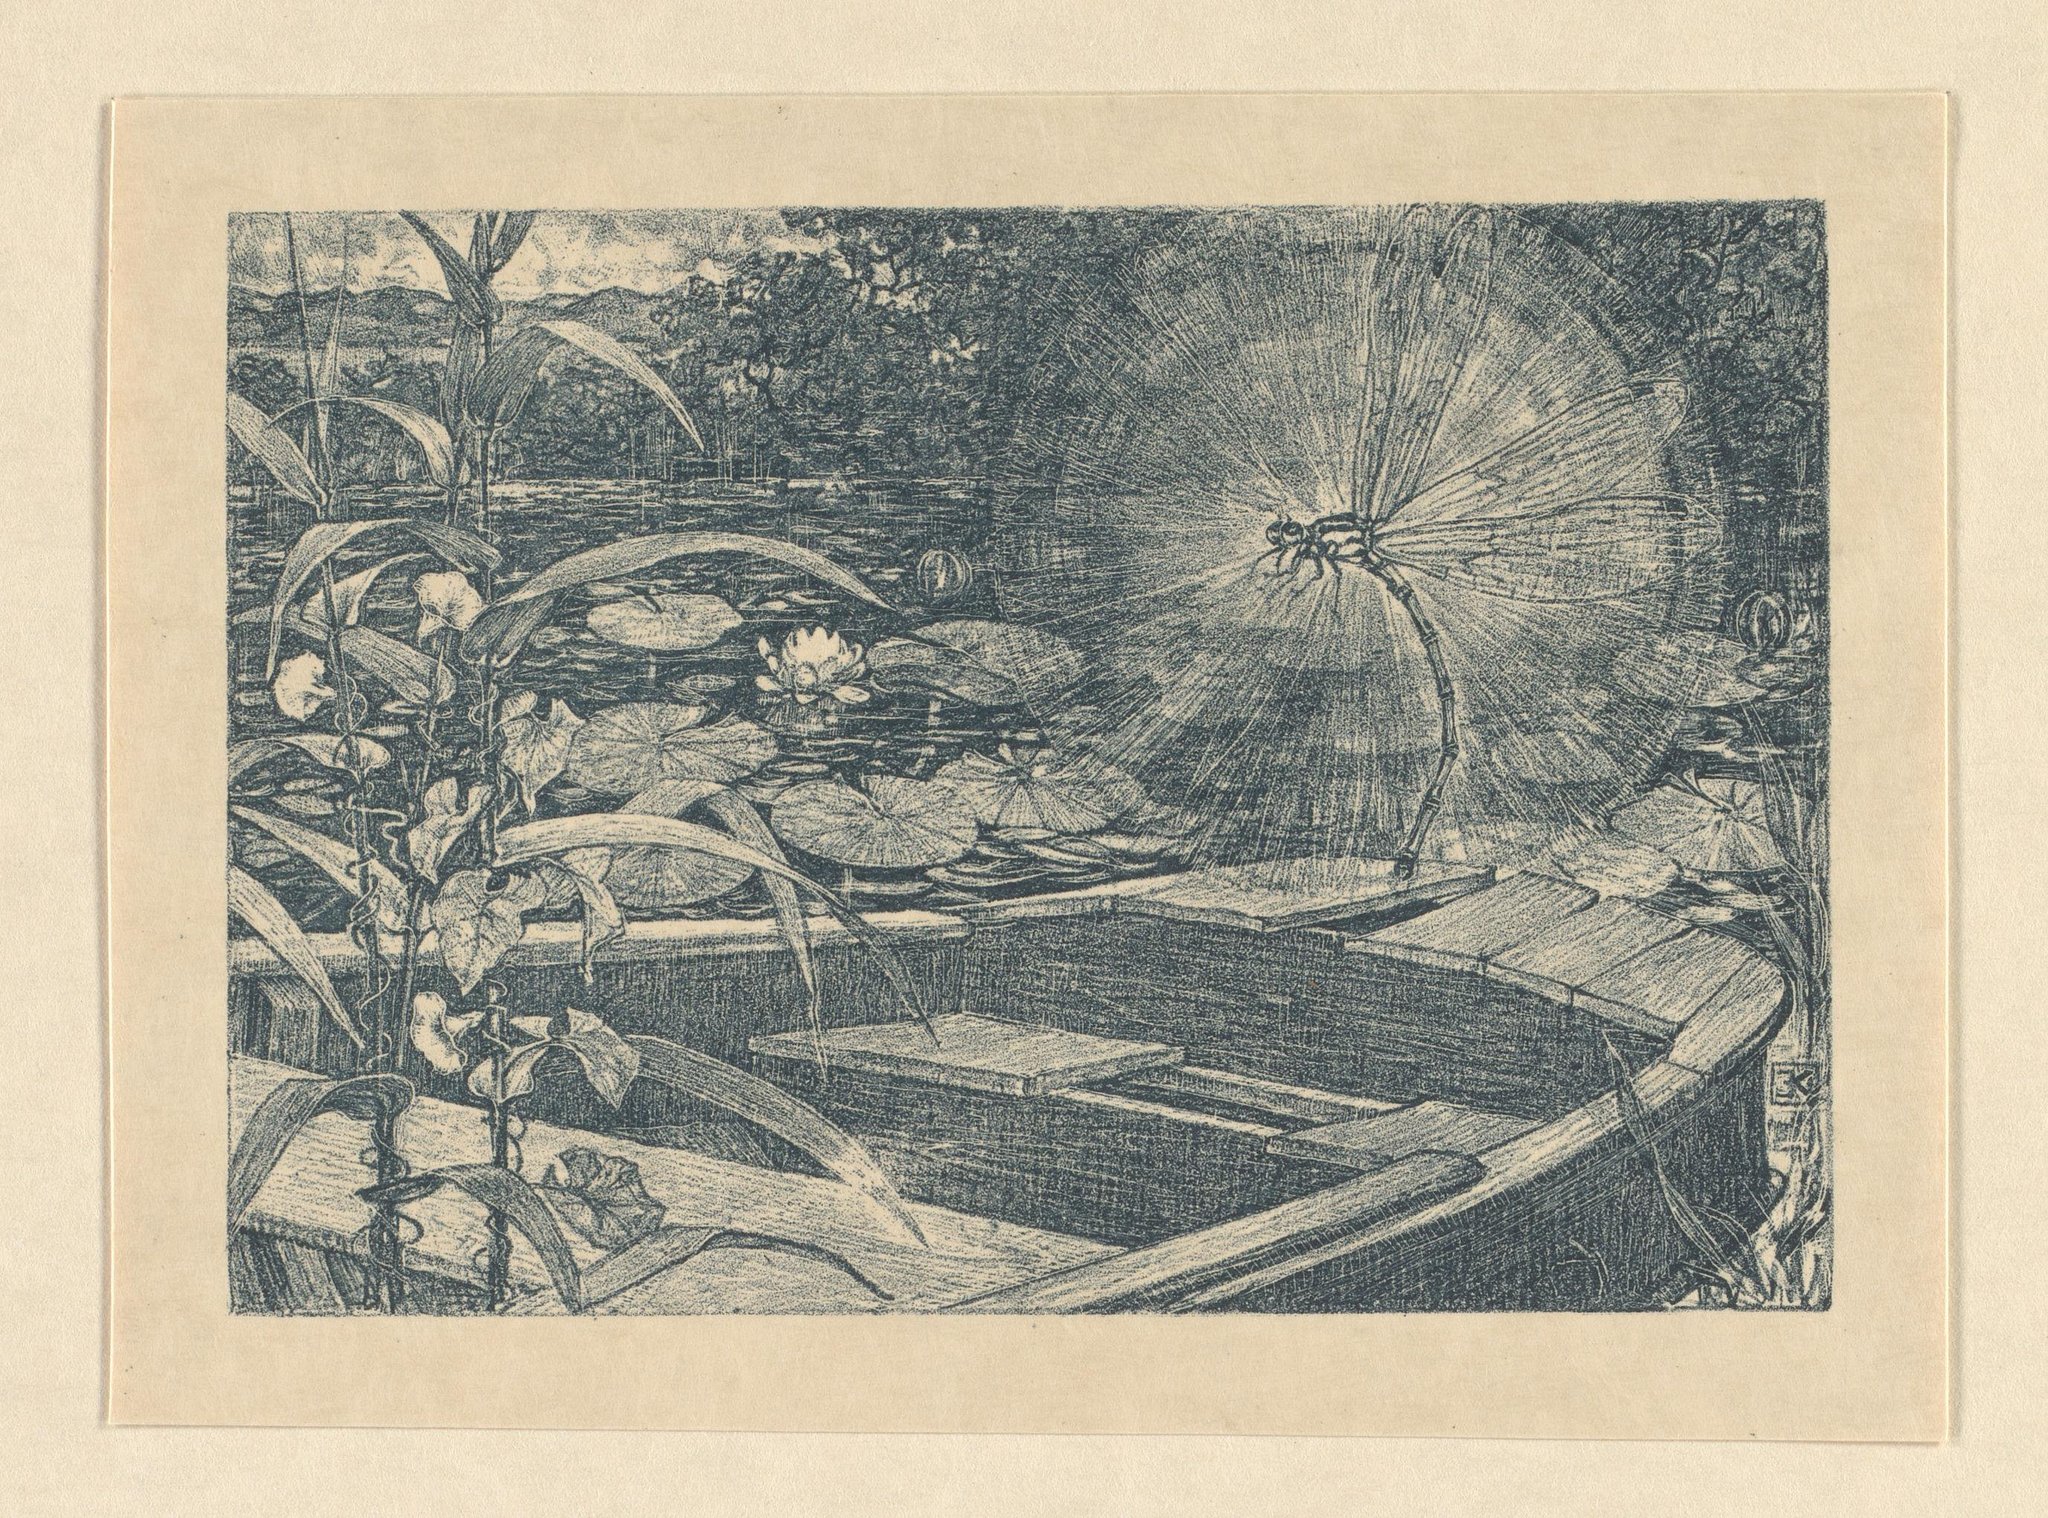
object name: boekillustratie ontwerp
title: Vijver met een roeiboot en een grote libelle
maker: edzard koning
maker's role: draughtsman, print maker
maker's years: 1869-1954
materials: paper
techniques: lithograph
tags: insects: dragon-fly, (van eeden, de kleine johannes) specific works of literature (with author, title), rowing-boat, canoe, etc., pond, pool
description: Ontwerp voor: Eeden, Frederik van. De kleine Johannes. Den Haag: Mouton & Co., 1898, p. 15.